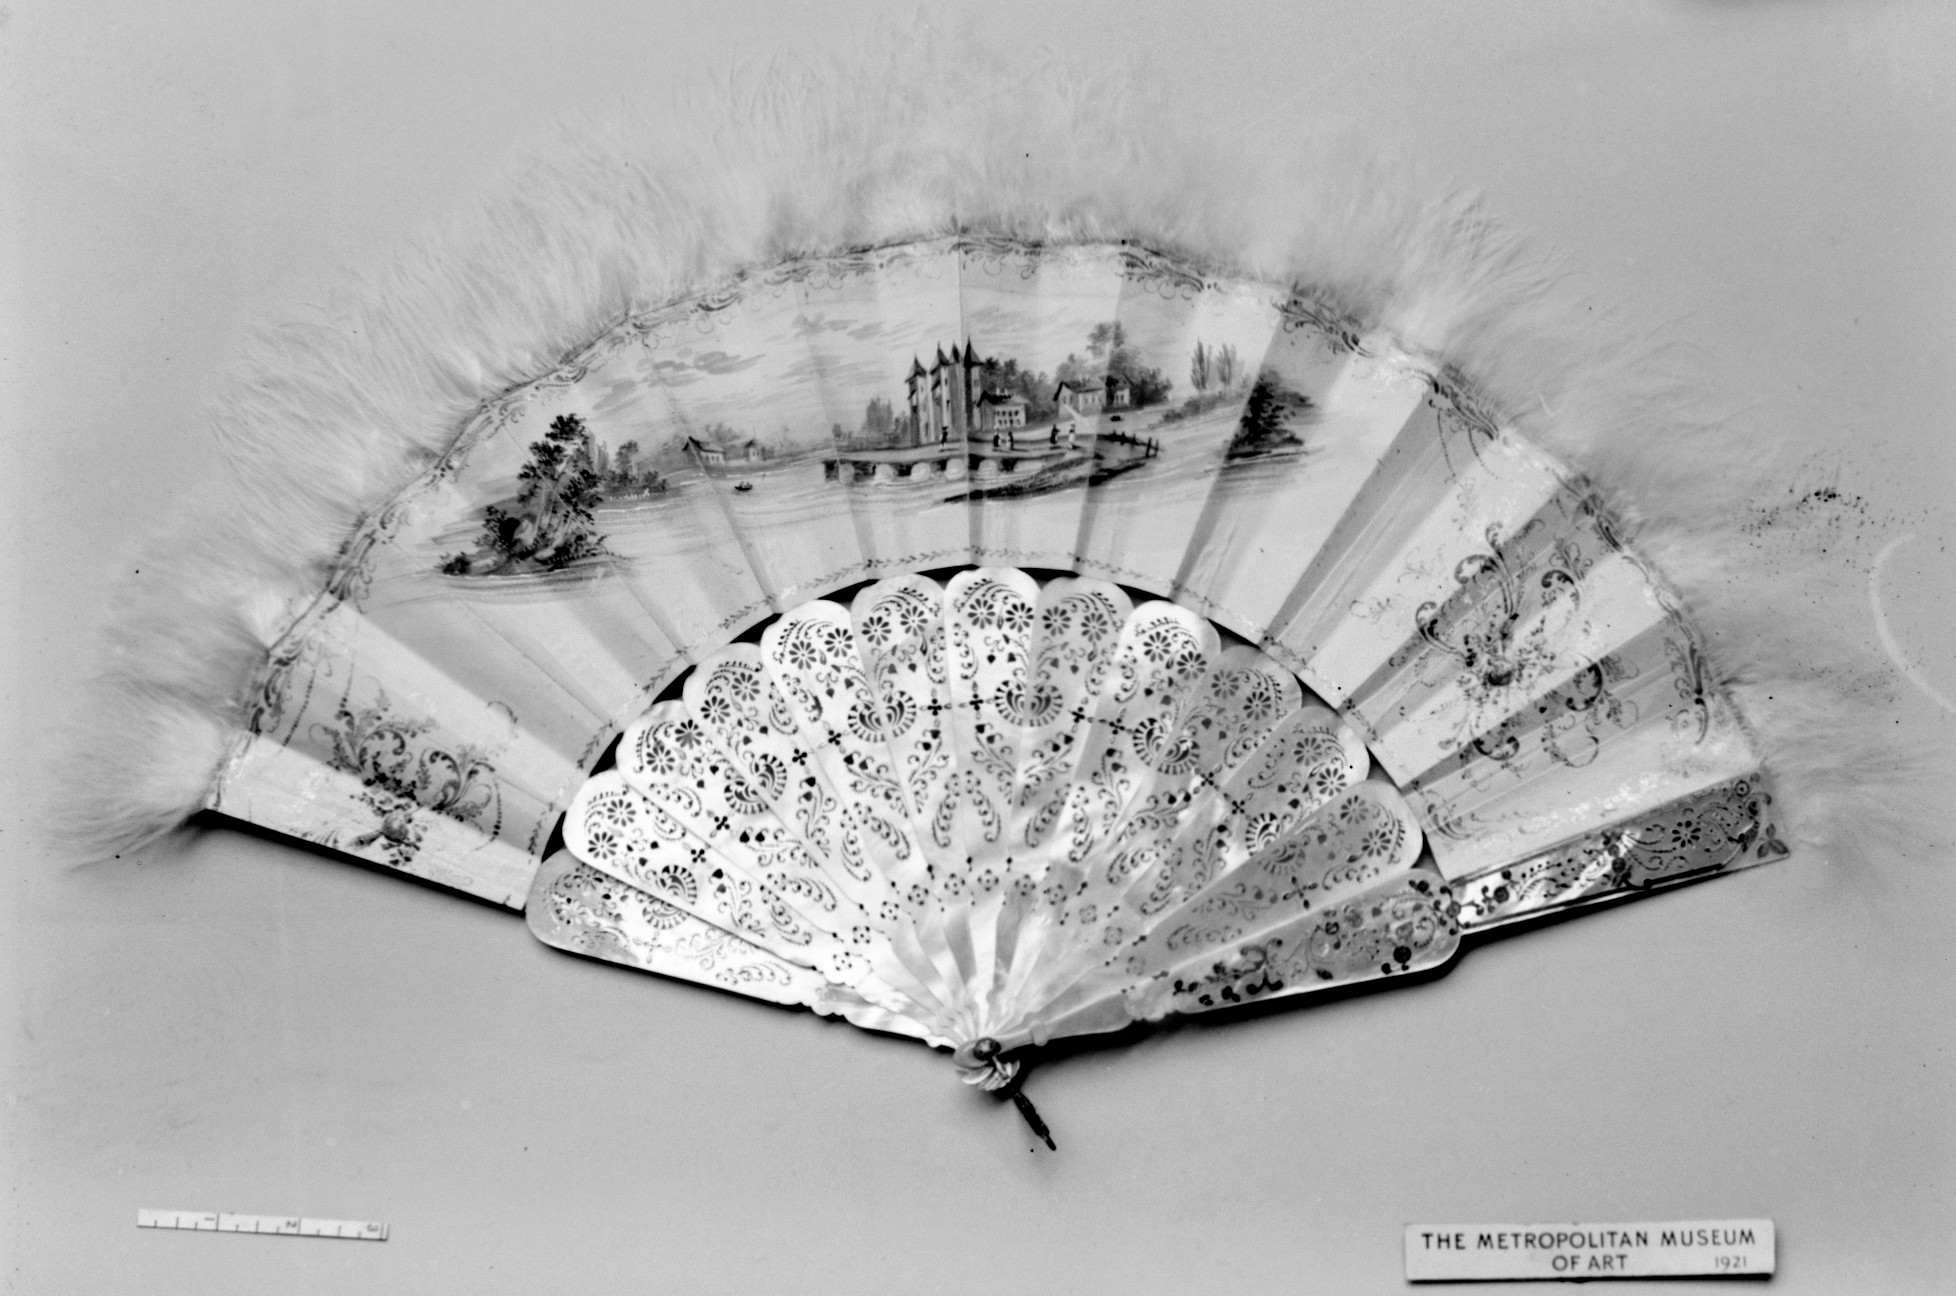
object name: fan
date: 1830-1850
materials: down, mother of pearl, silver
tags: houses